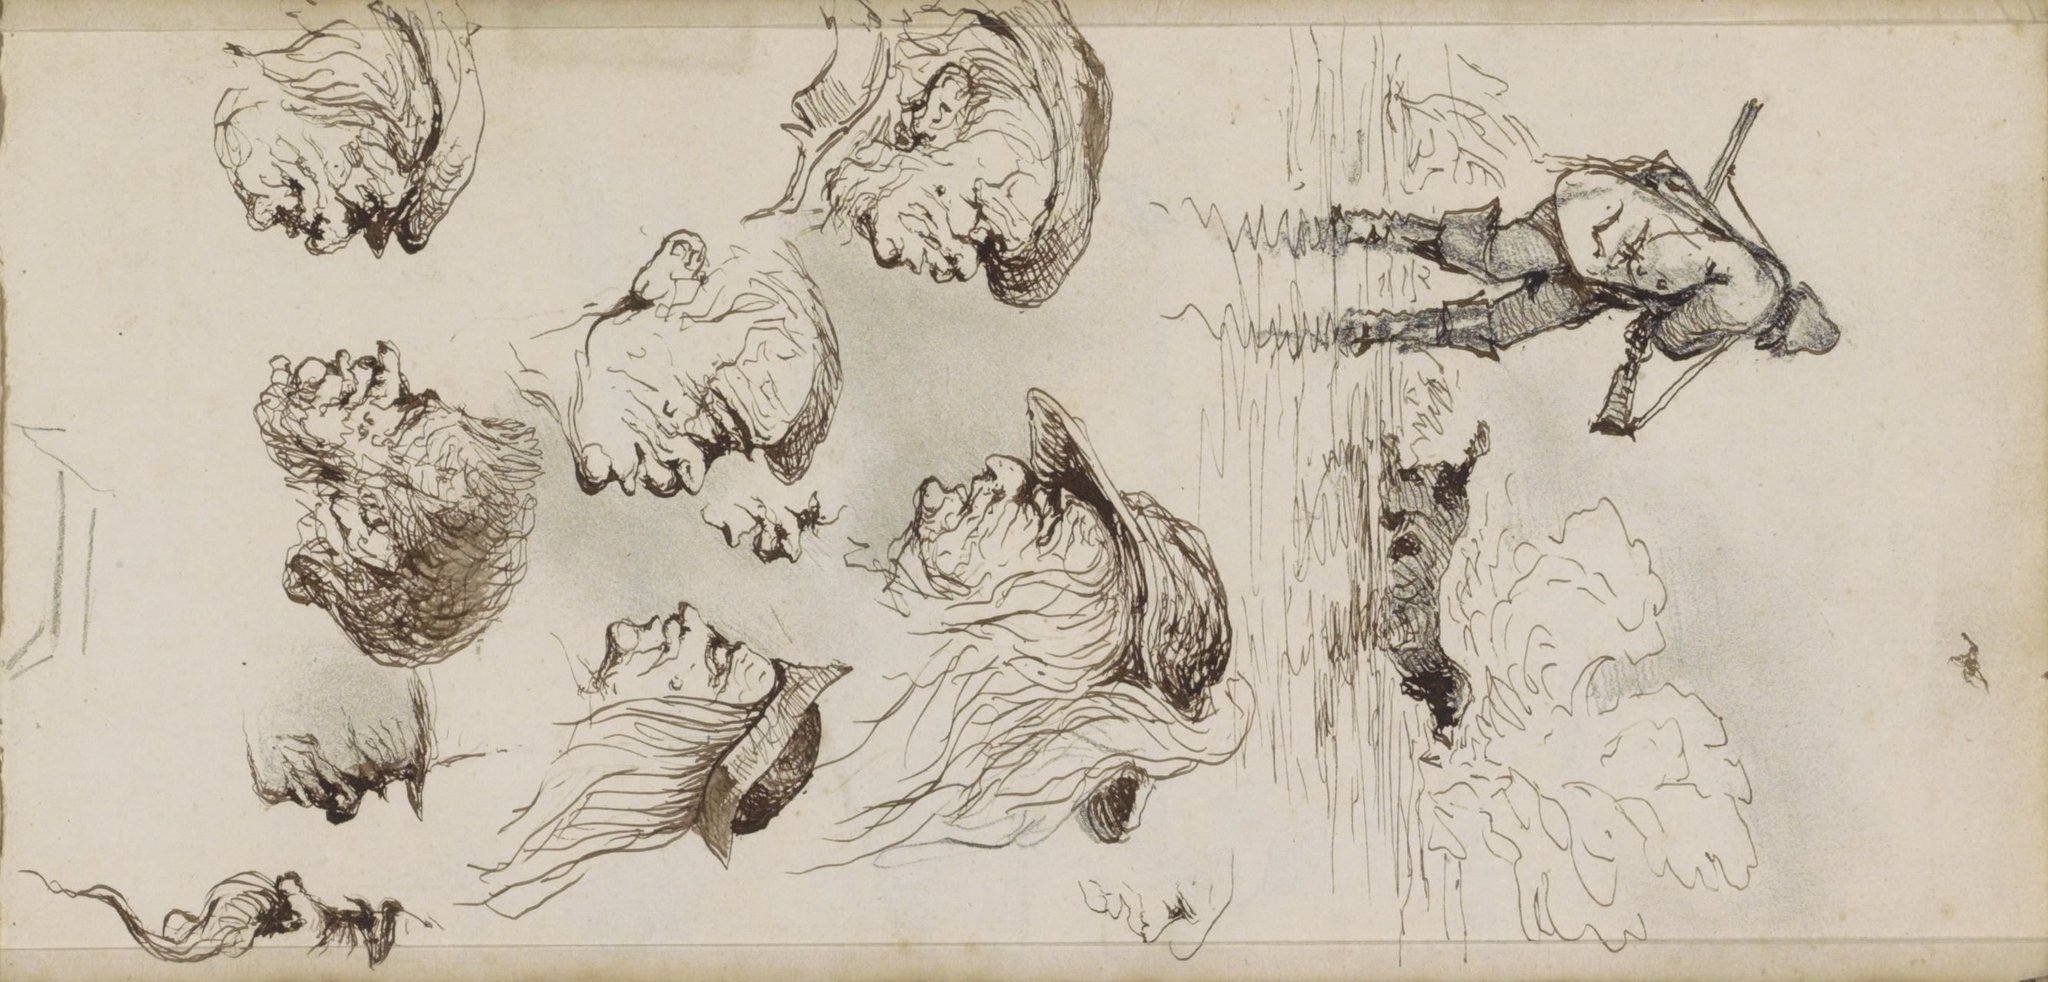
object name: sketchbook leaf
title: Karikaturale mannenkoppen en een jager met hond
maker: johannes tavenraat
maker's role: draughtsman, painter, print maker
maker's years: 1809-1881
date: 1840-1868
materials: ink, paper, pencil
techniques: pen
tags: hunter, adult man, landscapes with waters, waterscapes, seascapes (in the temperate zone), head-gear: hat (+ men's clothes), dog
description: De jager staat met kaplaarzen in het water. Blad 63 recto uit een schetsboek met 63 bladen.